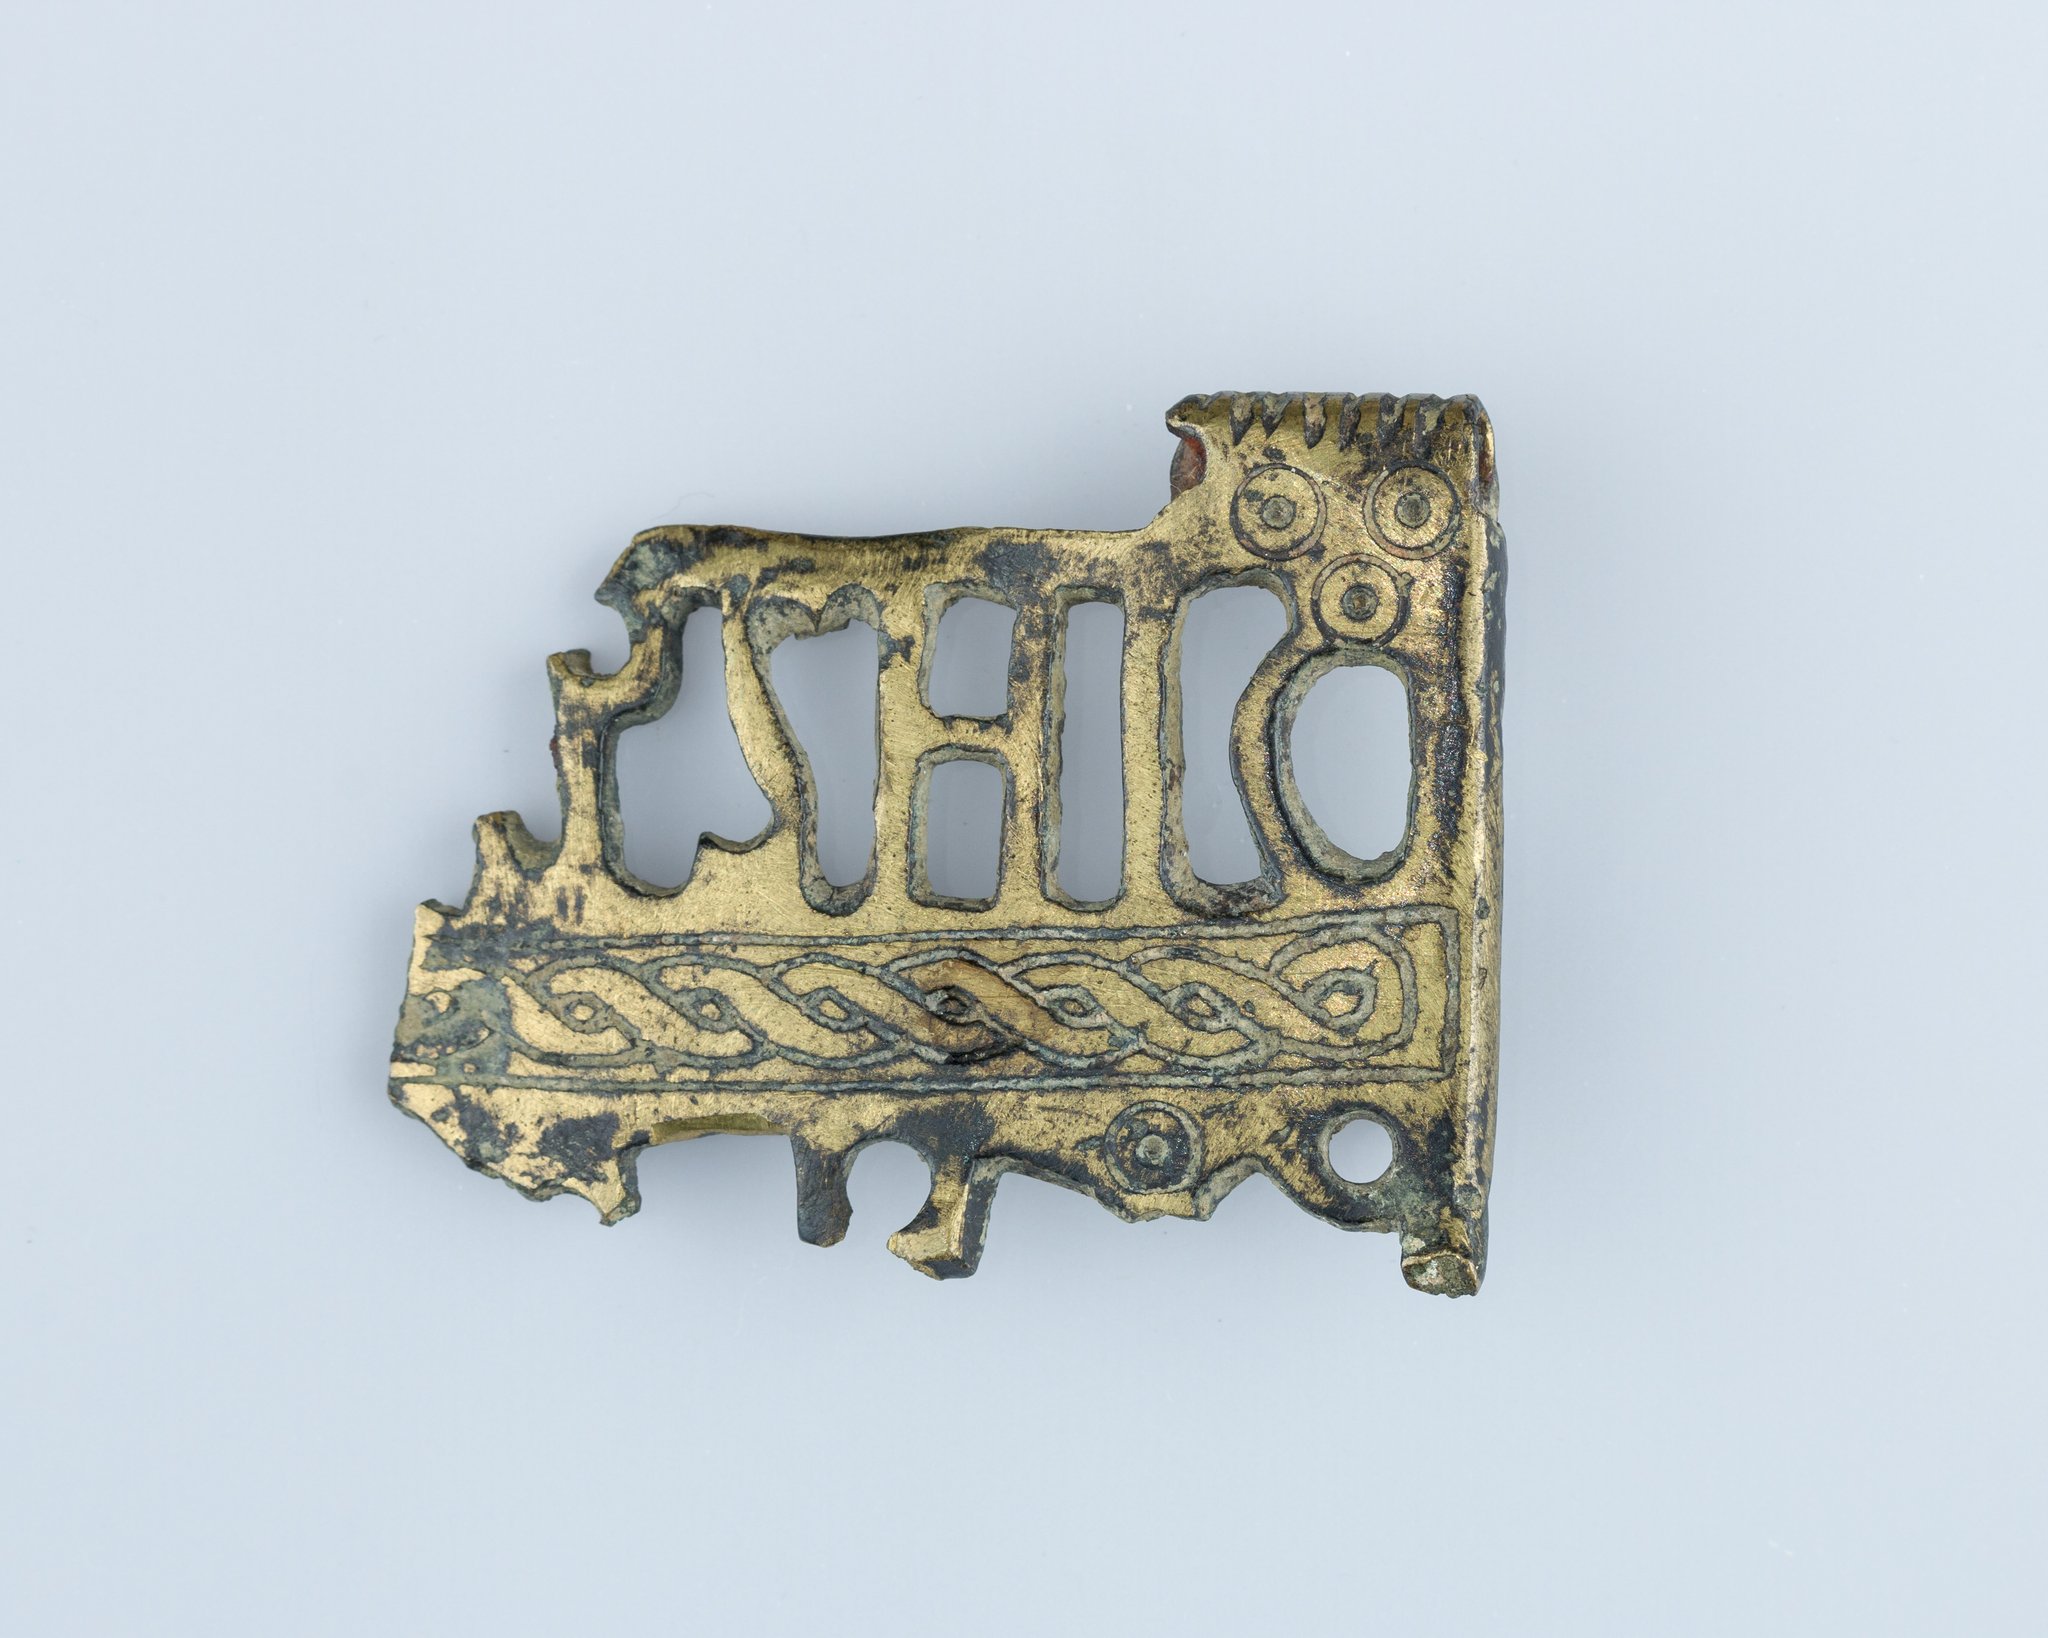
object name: buckle shank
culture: visigothic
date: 567-700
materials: copper alloy, gold, iron